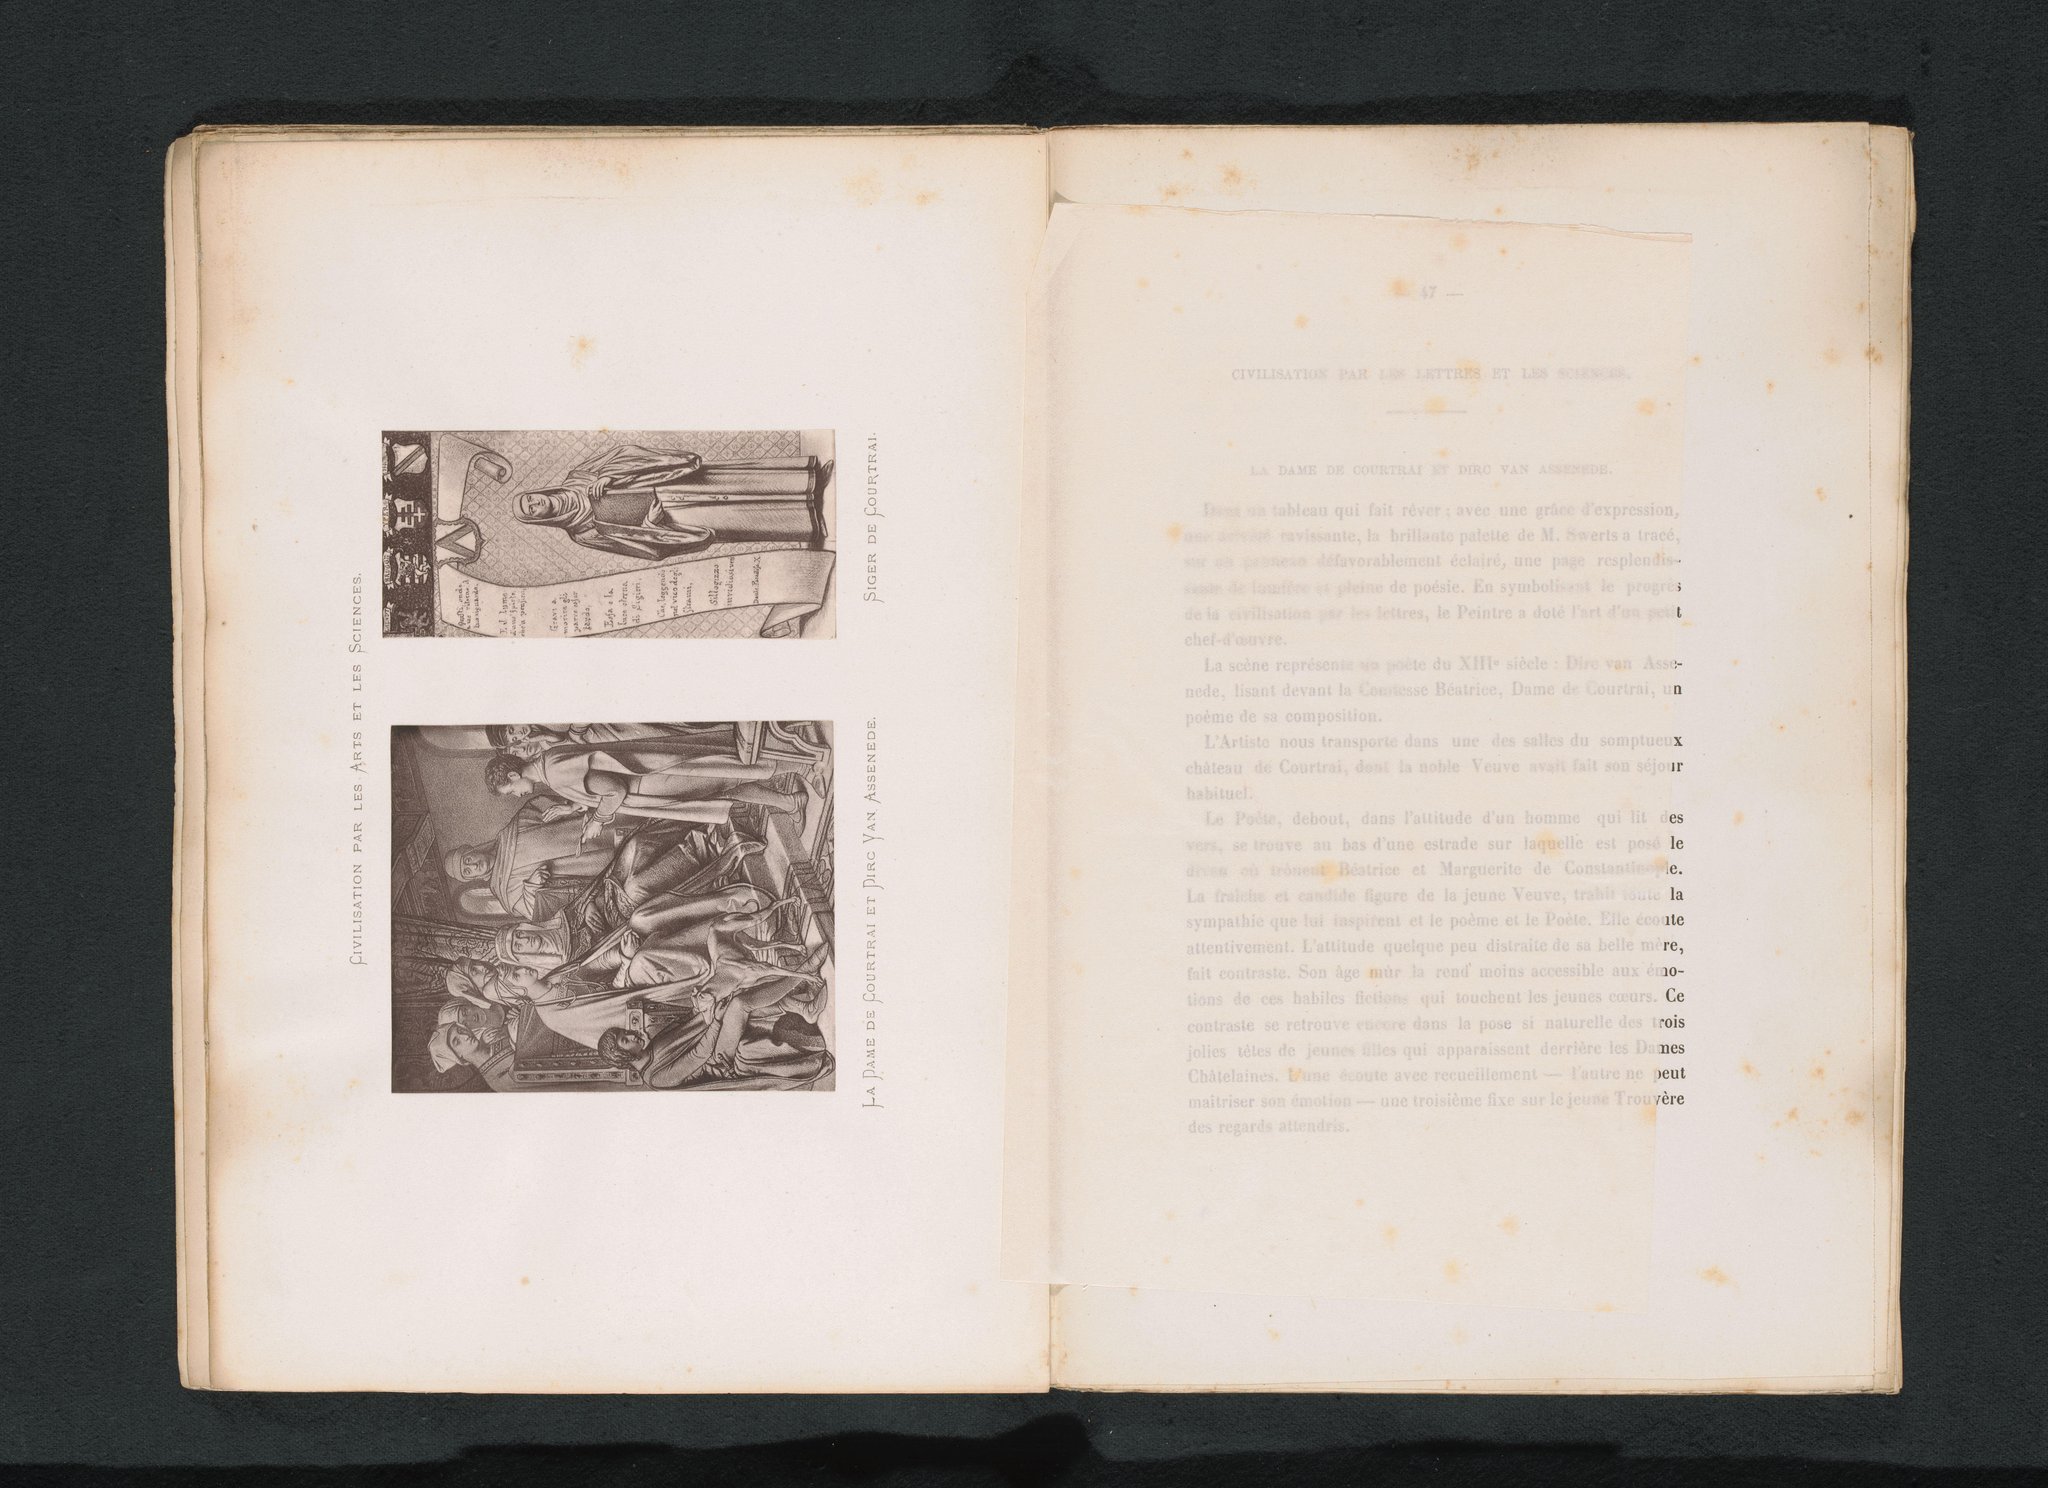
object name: photomechanical print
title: Siger de Courtrai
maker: Anonymous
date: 1871-1876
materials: paper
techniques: woodburytype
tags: scholar, philosopher, regular clerics, e.g. jesuits, redemptorists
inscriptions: inscription: ‘Civilisation par les Arts et les Sciences.’